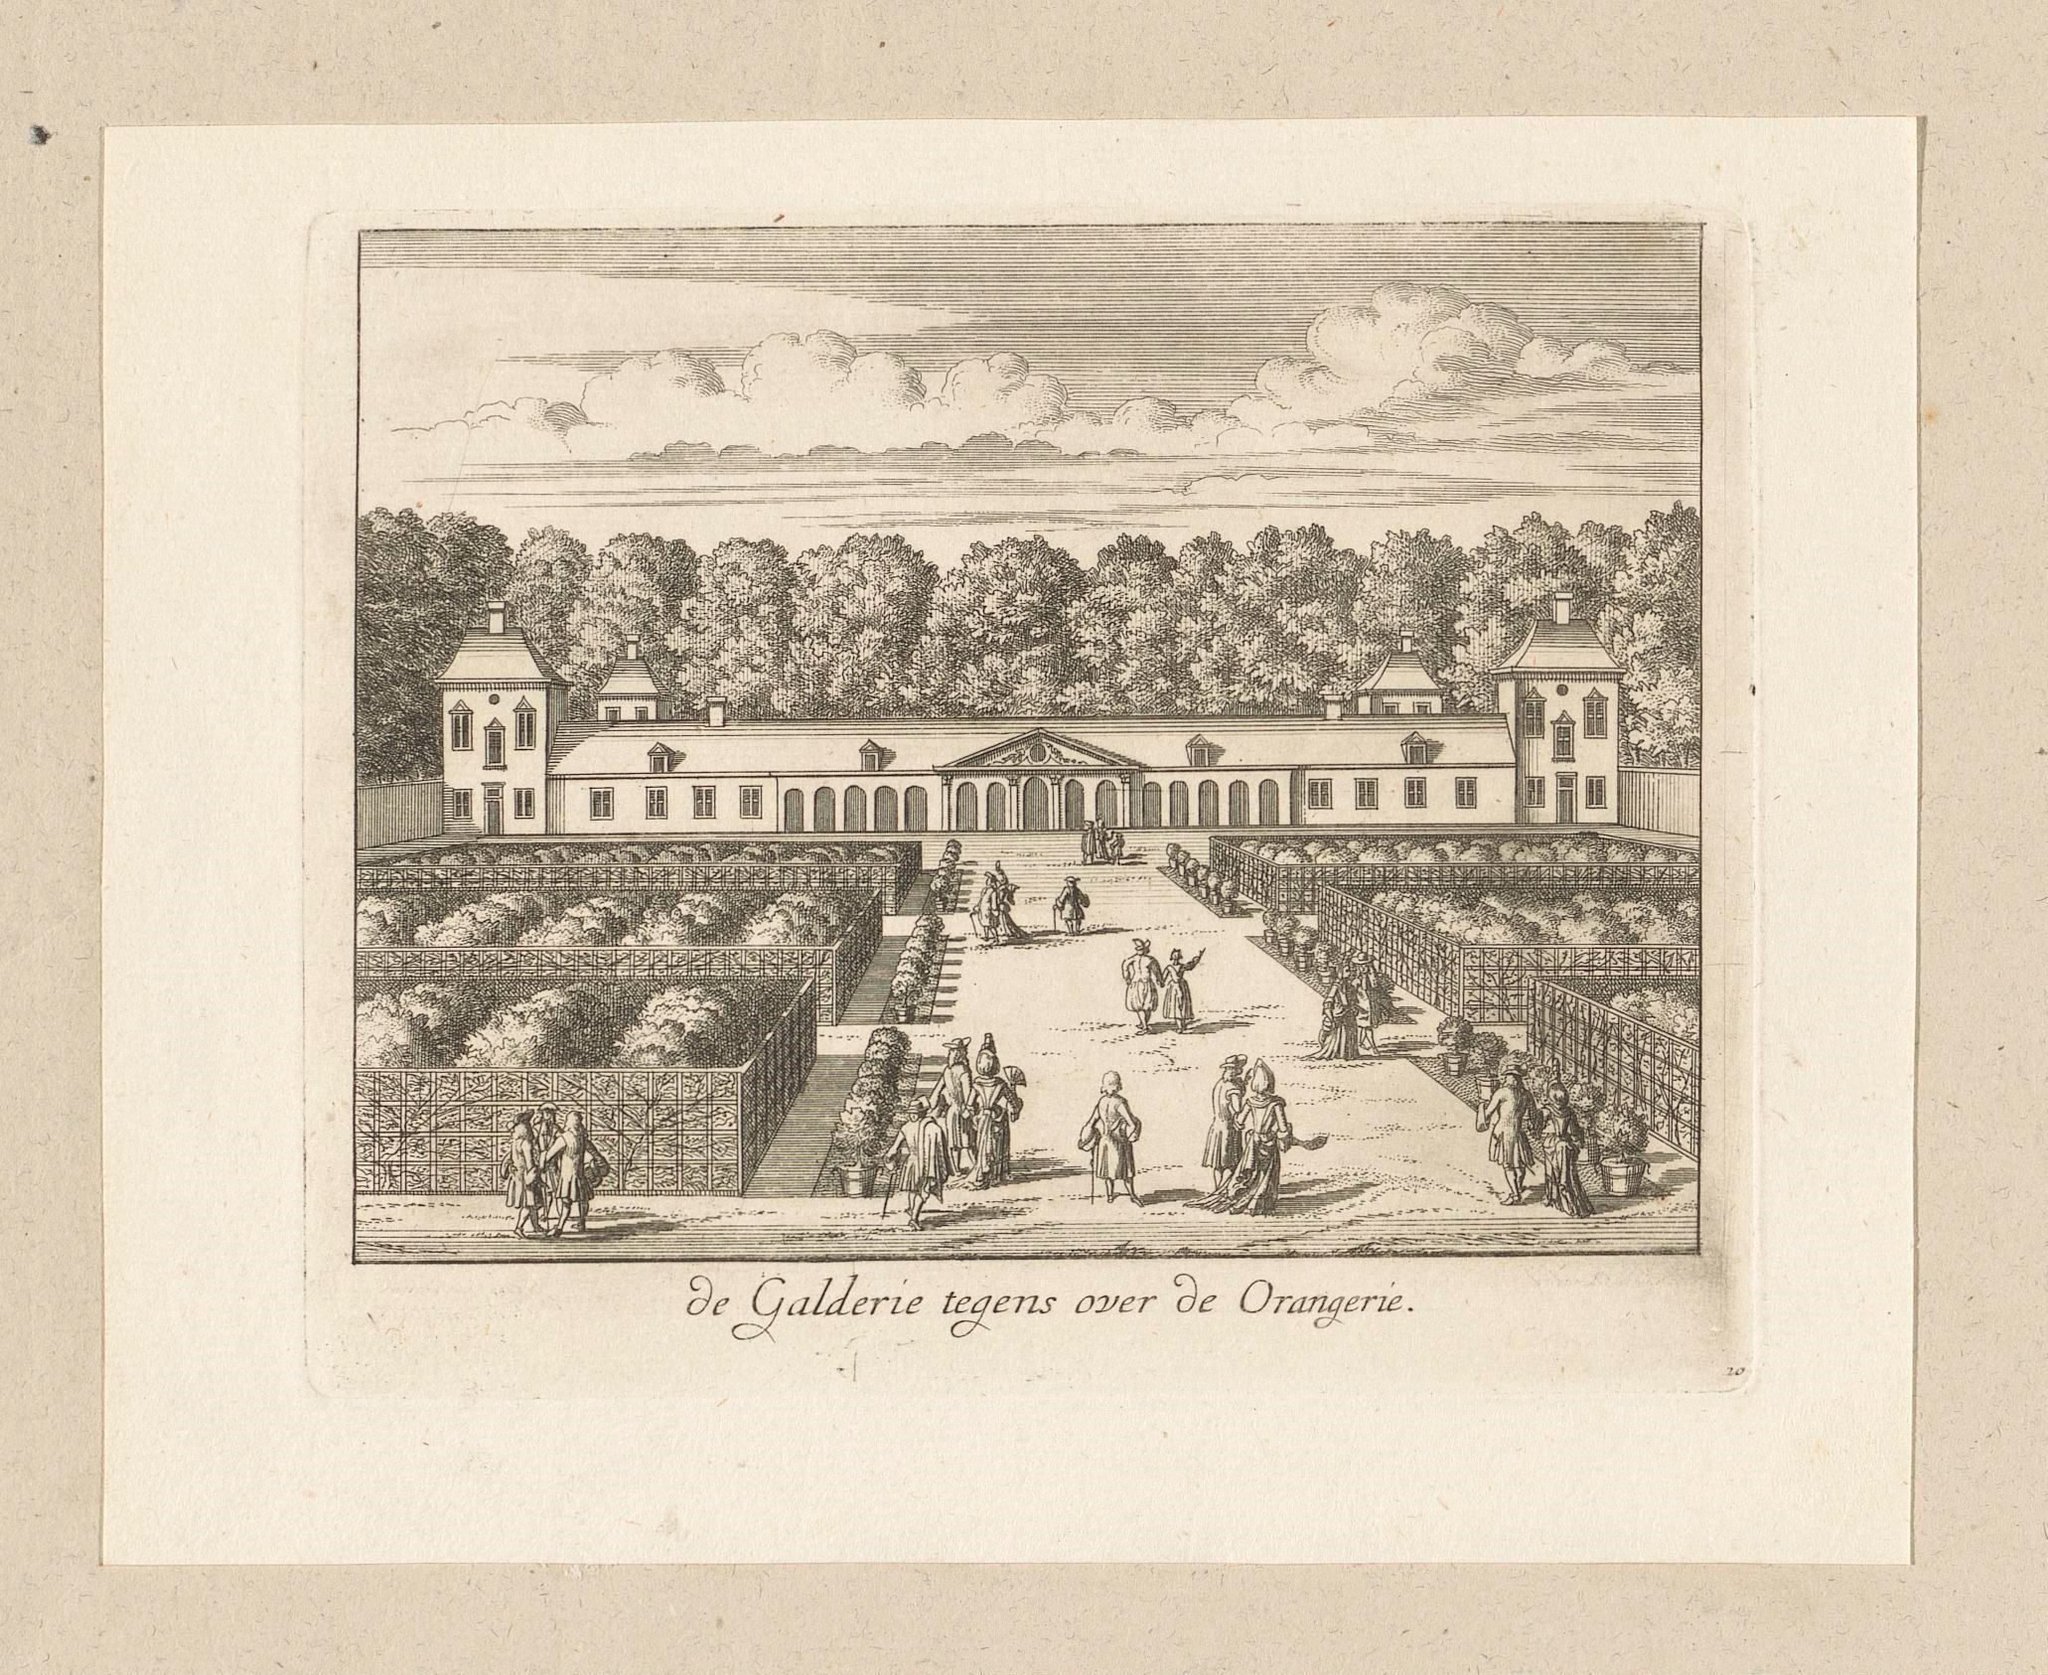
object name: print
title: Zestien prenten van Paleis Honselaarsdijk (Danckerts / Covens en Mortier)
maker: cornelis danckerts (ii)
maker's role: print maker, publisher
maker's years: 1664-1717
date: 1696-1717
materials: paper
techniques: etching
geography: amsterdam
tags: palace, french or architectonic garden; formal garden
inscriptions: collector's mark: Lugt 2233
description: Parklandschap met galerij, gelegen tegenover de orangerie. Op de lanen flaneren groepjes wandelaars. Rechtsonder genummerd: 10. Prent uit een serie van zestien prenten van Paleis Honselaarsdijk.